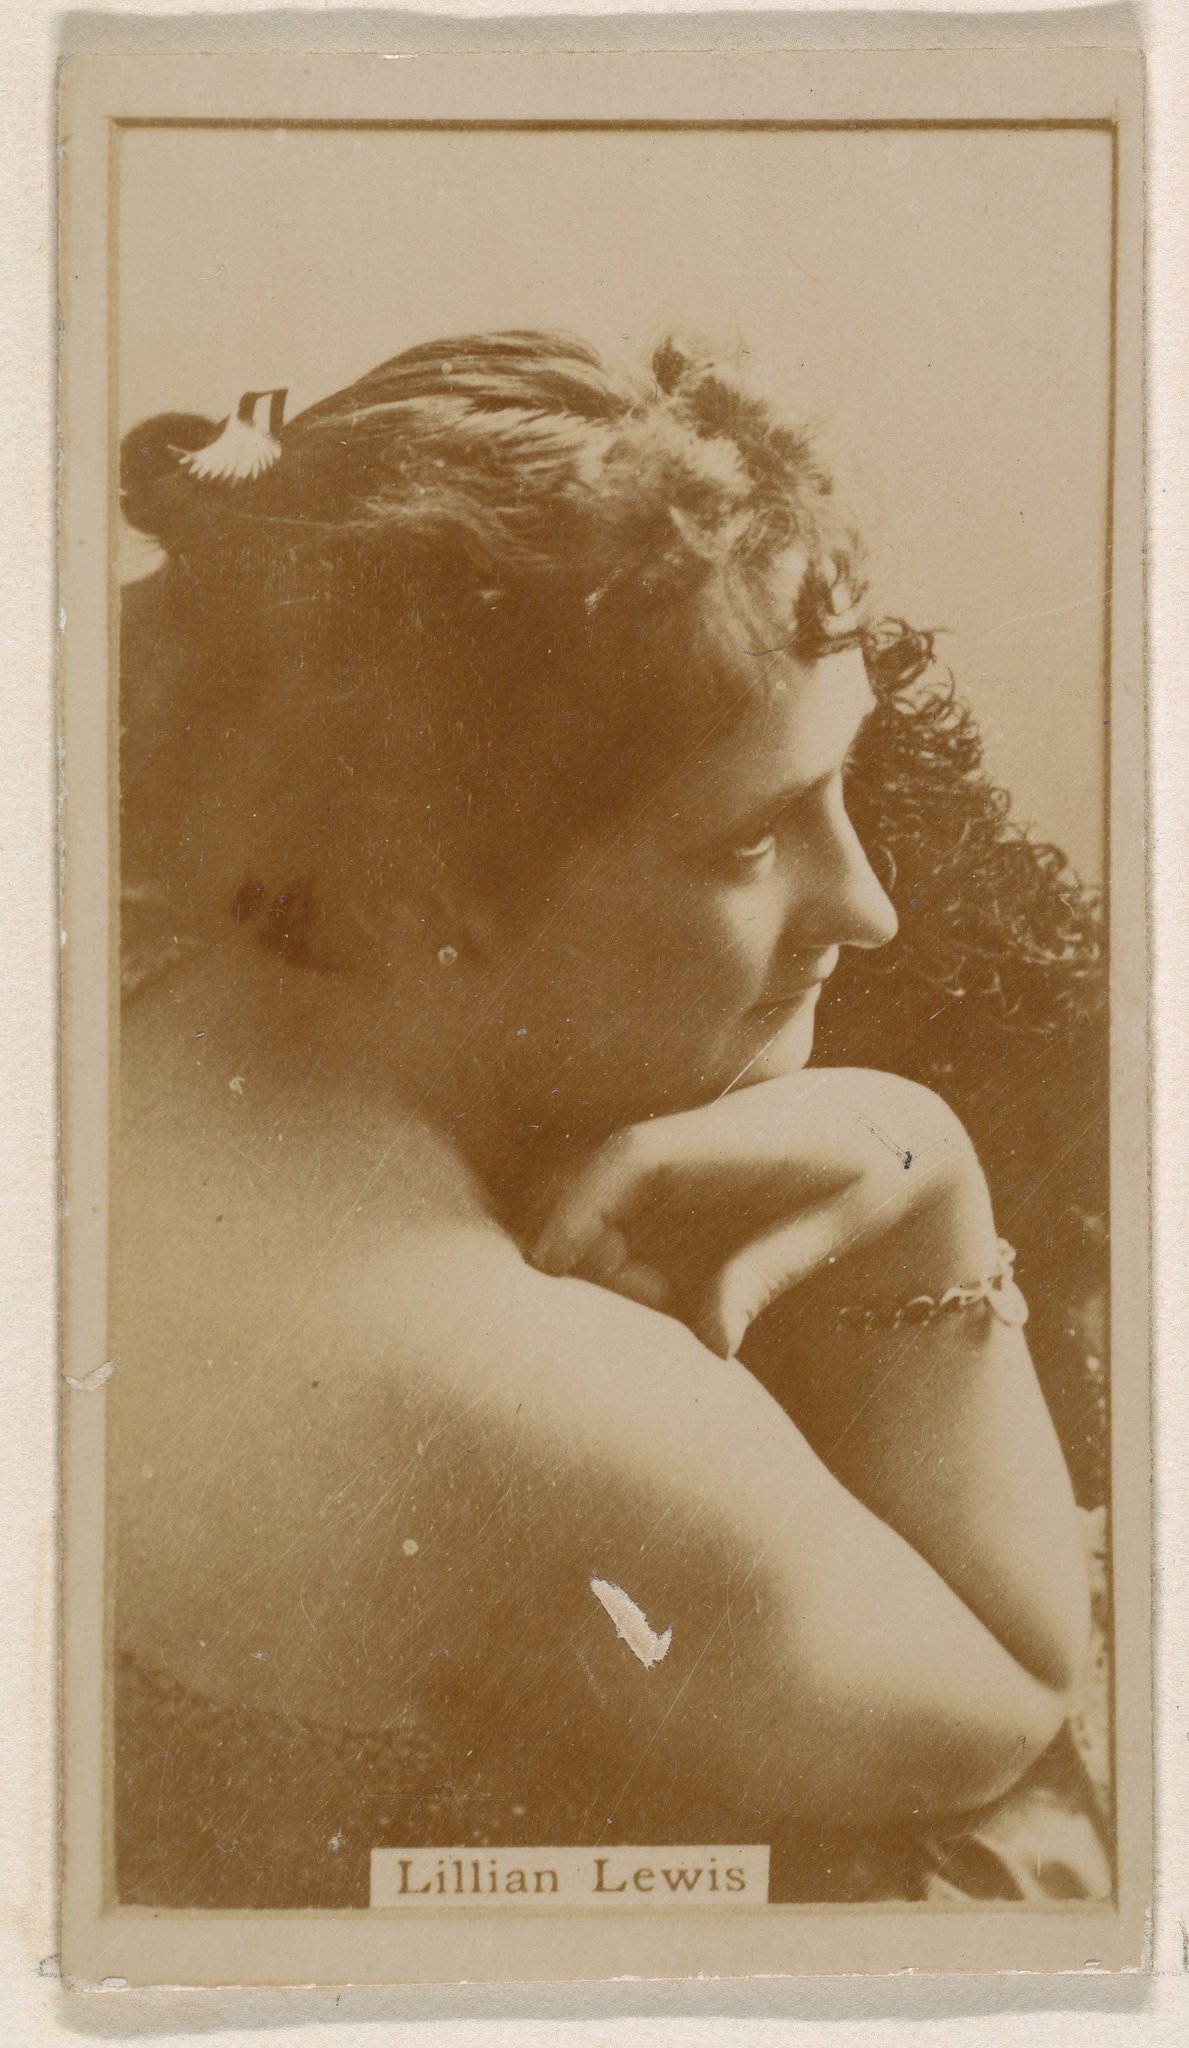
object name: photograph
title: Lillian Lewis, from the Actresses series (N245) issued by Kinney Brothers to promote Sweet Caporal Cigarettes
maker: kinney brothers tobacco company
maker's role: publisher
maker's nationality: american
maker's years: 1869-2011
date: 1890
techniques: albumen silver print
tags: women,actresses